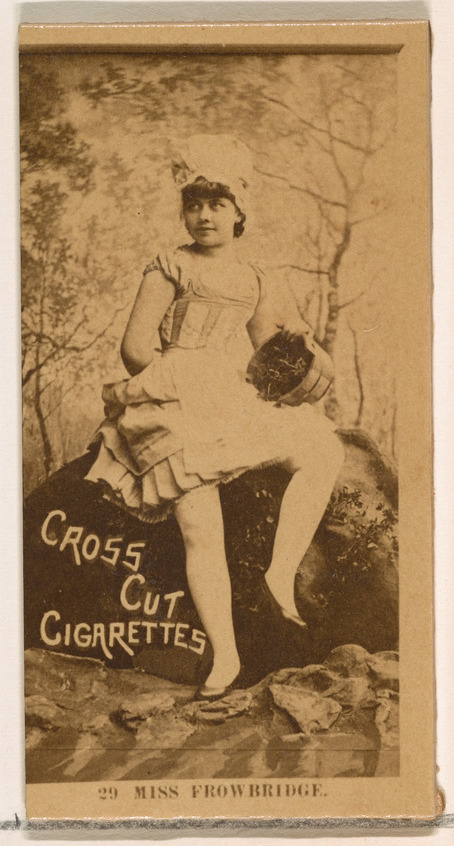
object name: print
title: Card Number 29, Miss Frowbridge, from the Actors and Actresses series (N145-2) issued by Duke Sons & Co. to promote Cross Cut Cigarettes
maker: w. duke, sons & co.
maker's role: publisher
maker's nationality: american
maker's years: 1870-1920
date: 1880-1889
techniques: albumen silver print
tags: portraits,women,actresses